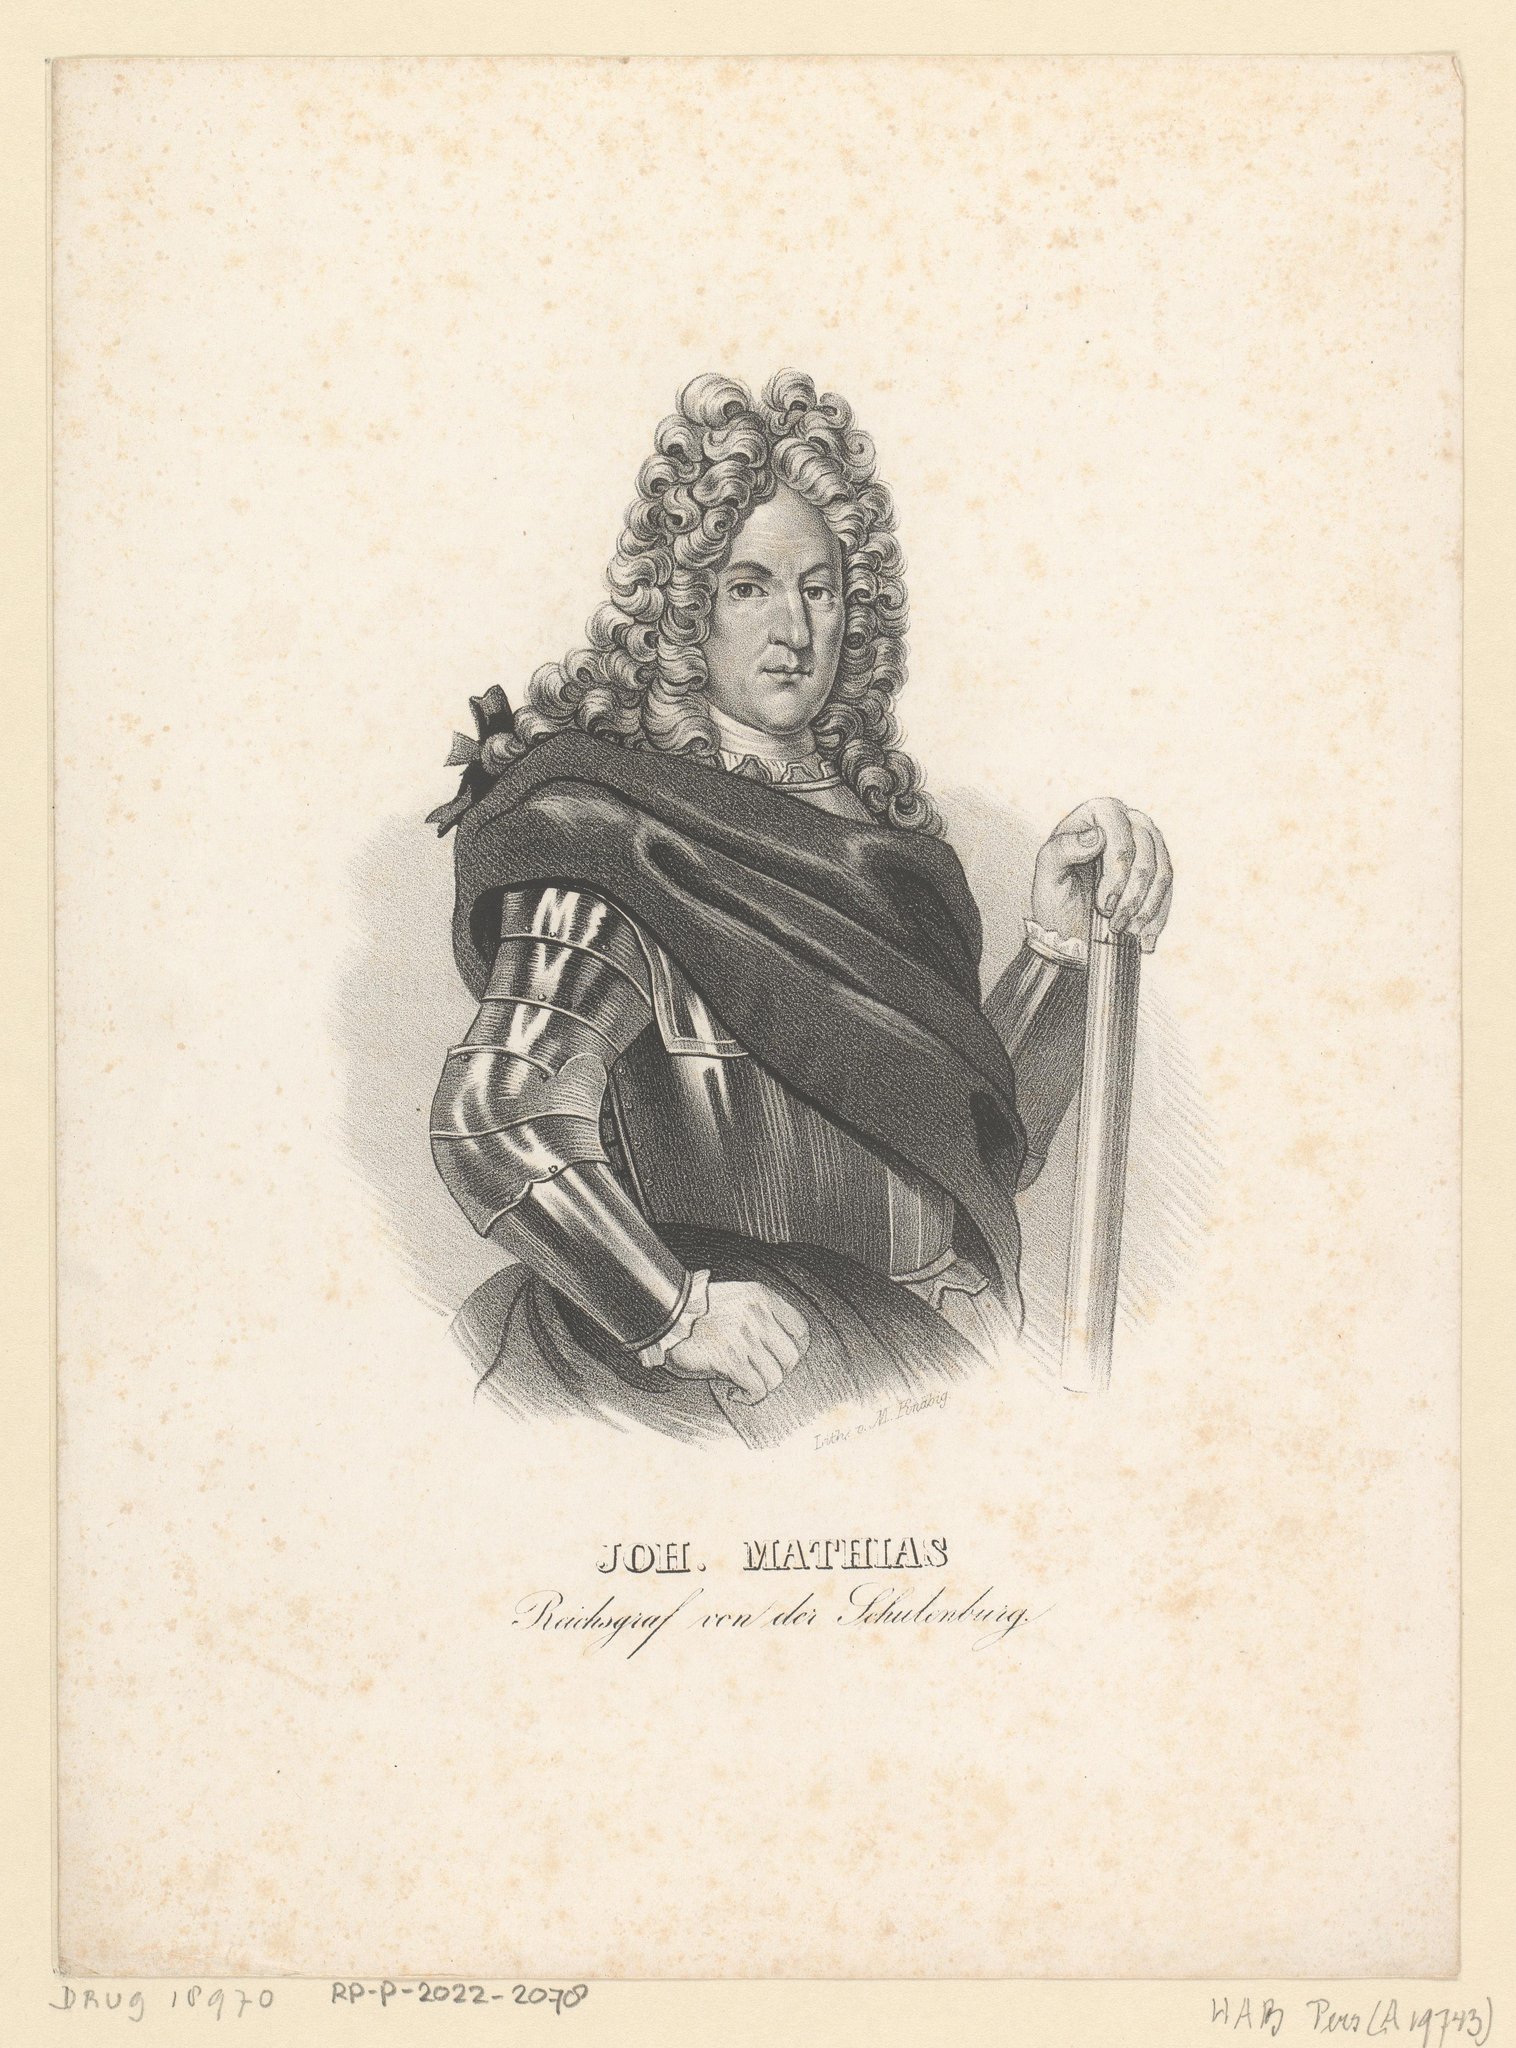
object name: print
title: Portret van Matthias Johann von der Schulenburg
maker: maximilian knäbig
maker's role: print maker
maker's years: 1804-1876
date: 1814-1876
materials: paper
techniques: lithograph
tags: commander-in-chief, general, marshal, armour, historical persons, baton of general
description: Met eenregelig onderschrift in het Duits.